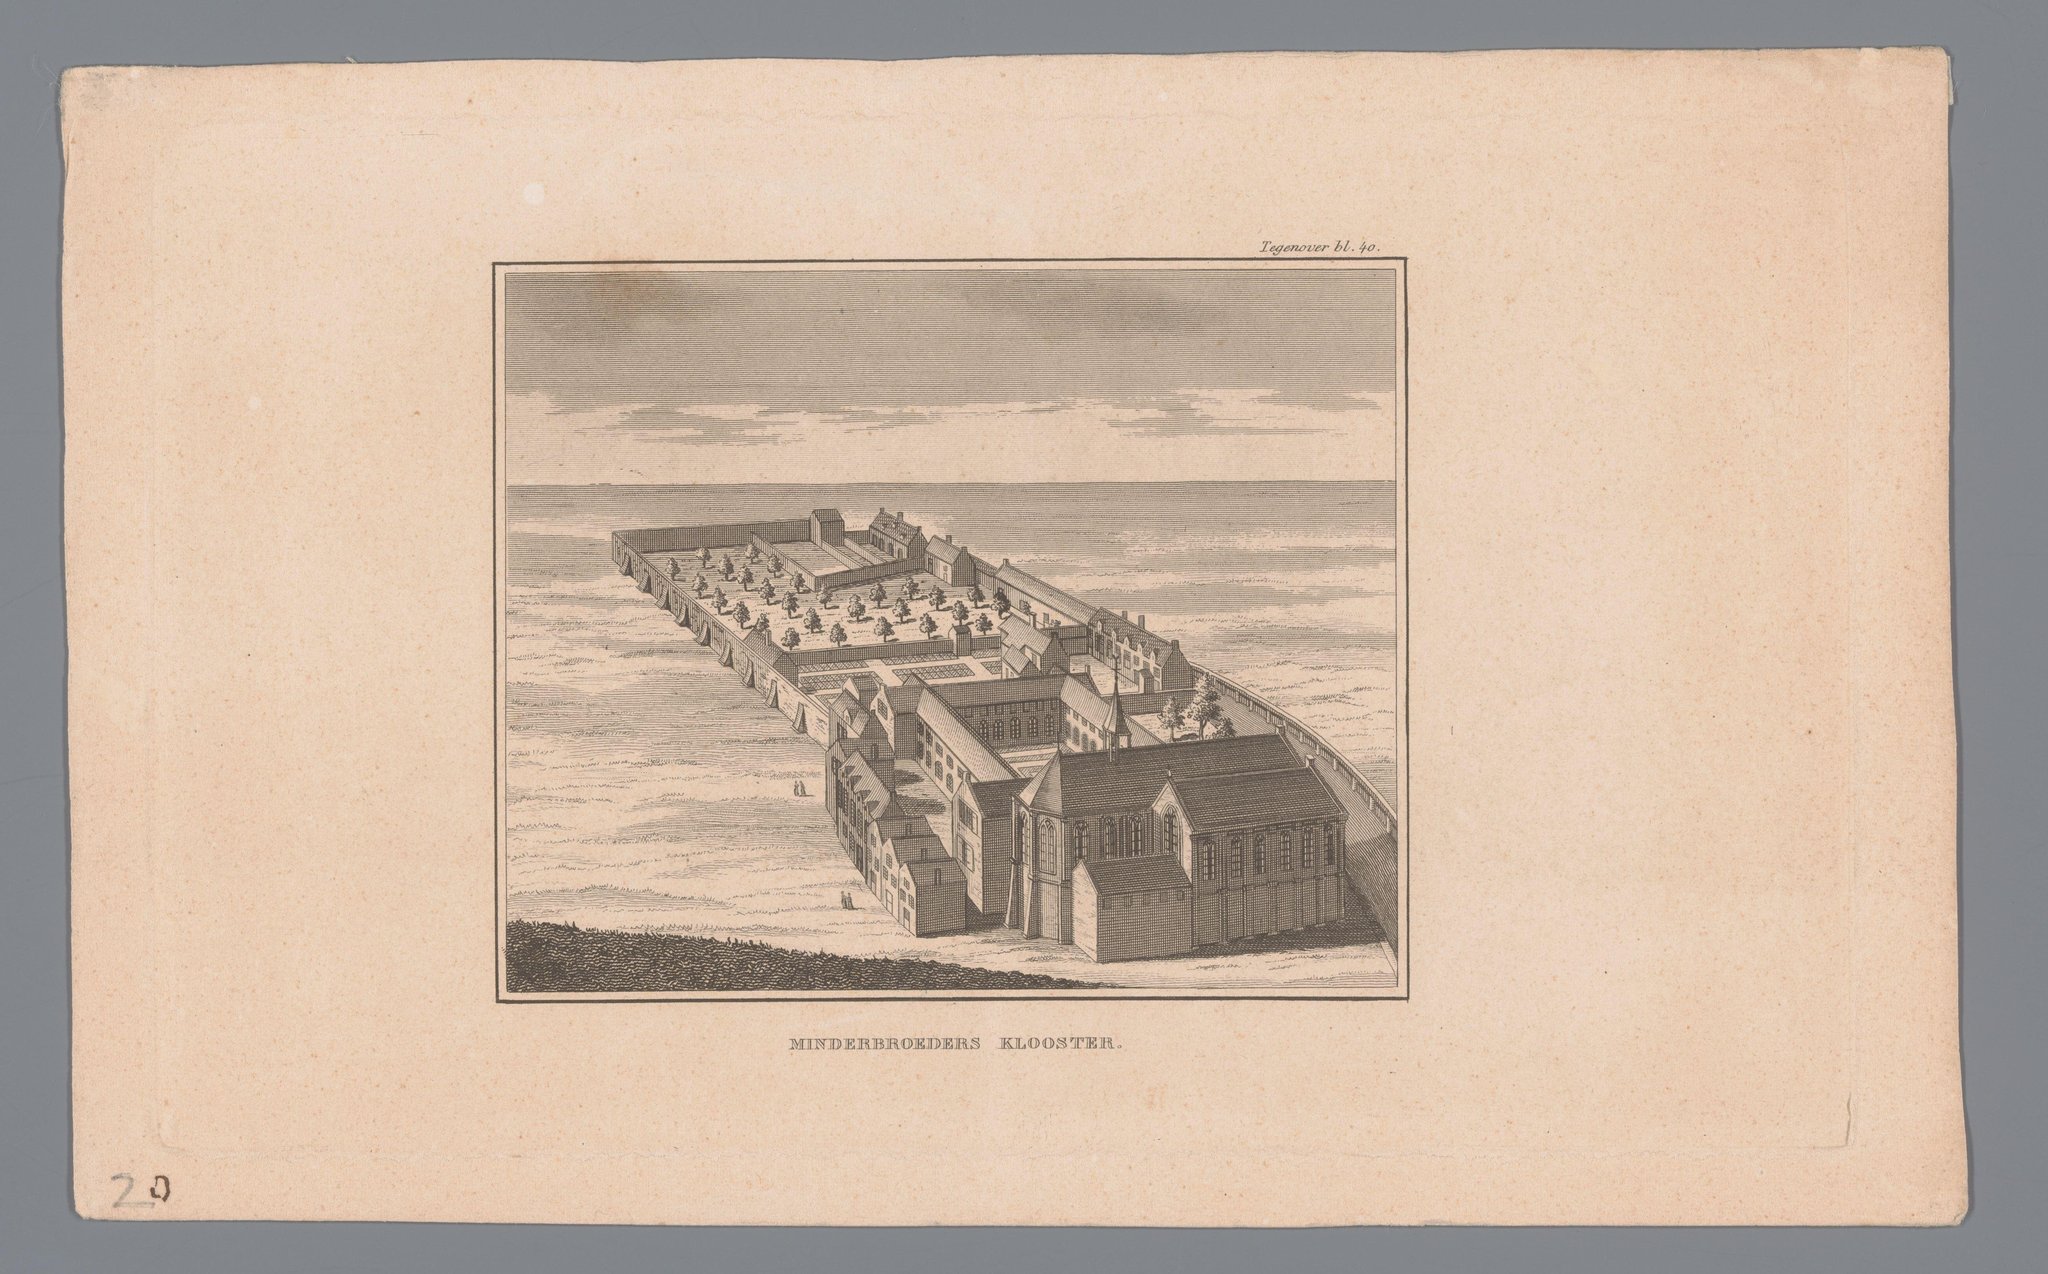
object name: print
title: Minderbroeders Klooster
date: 1800-1900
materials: paper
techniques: etching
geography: amsterdam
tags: abbey, monastery, convent ~ roman catholic church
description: Kopie naar een prent verschenen in: Long, Isaak Le. Historische beschryvinge van de Reformatie der stadt Amsterdam. Amsterdam: Johannes van Septeren, 1729.